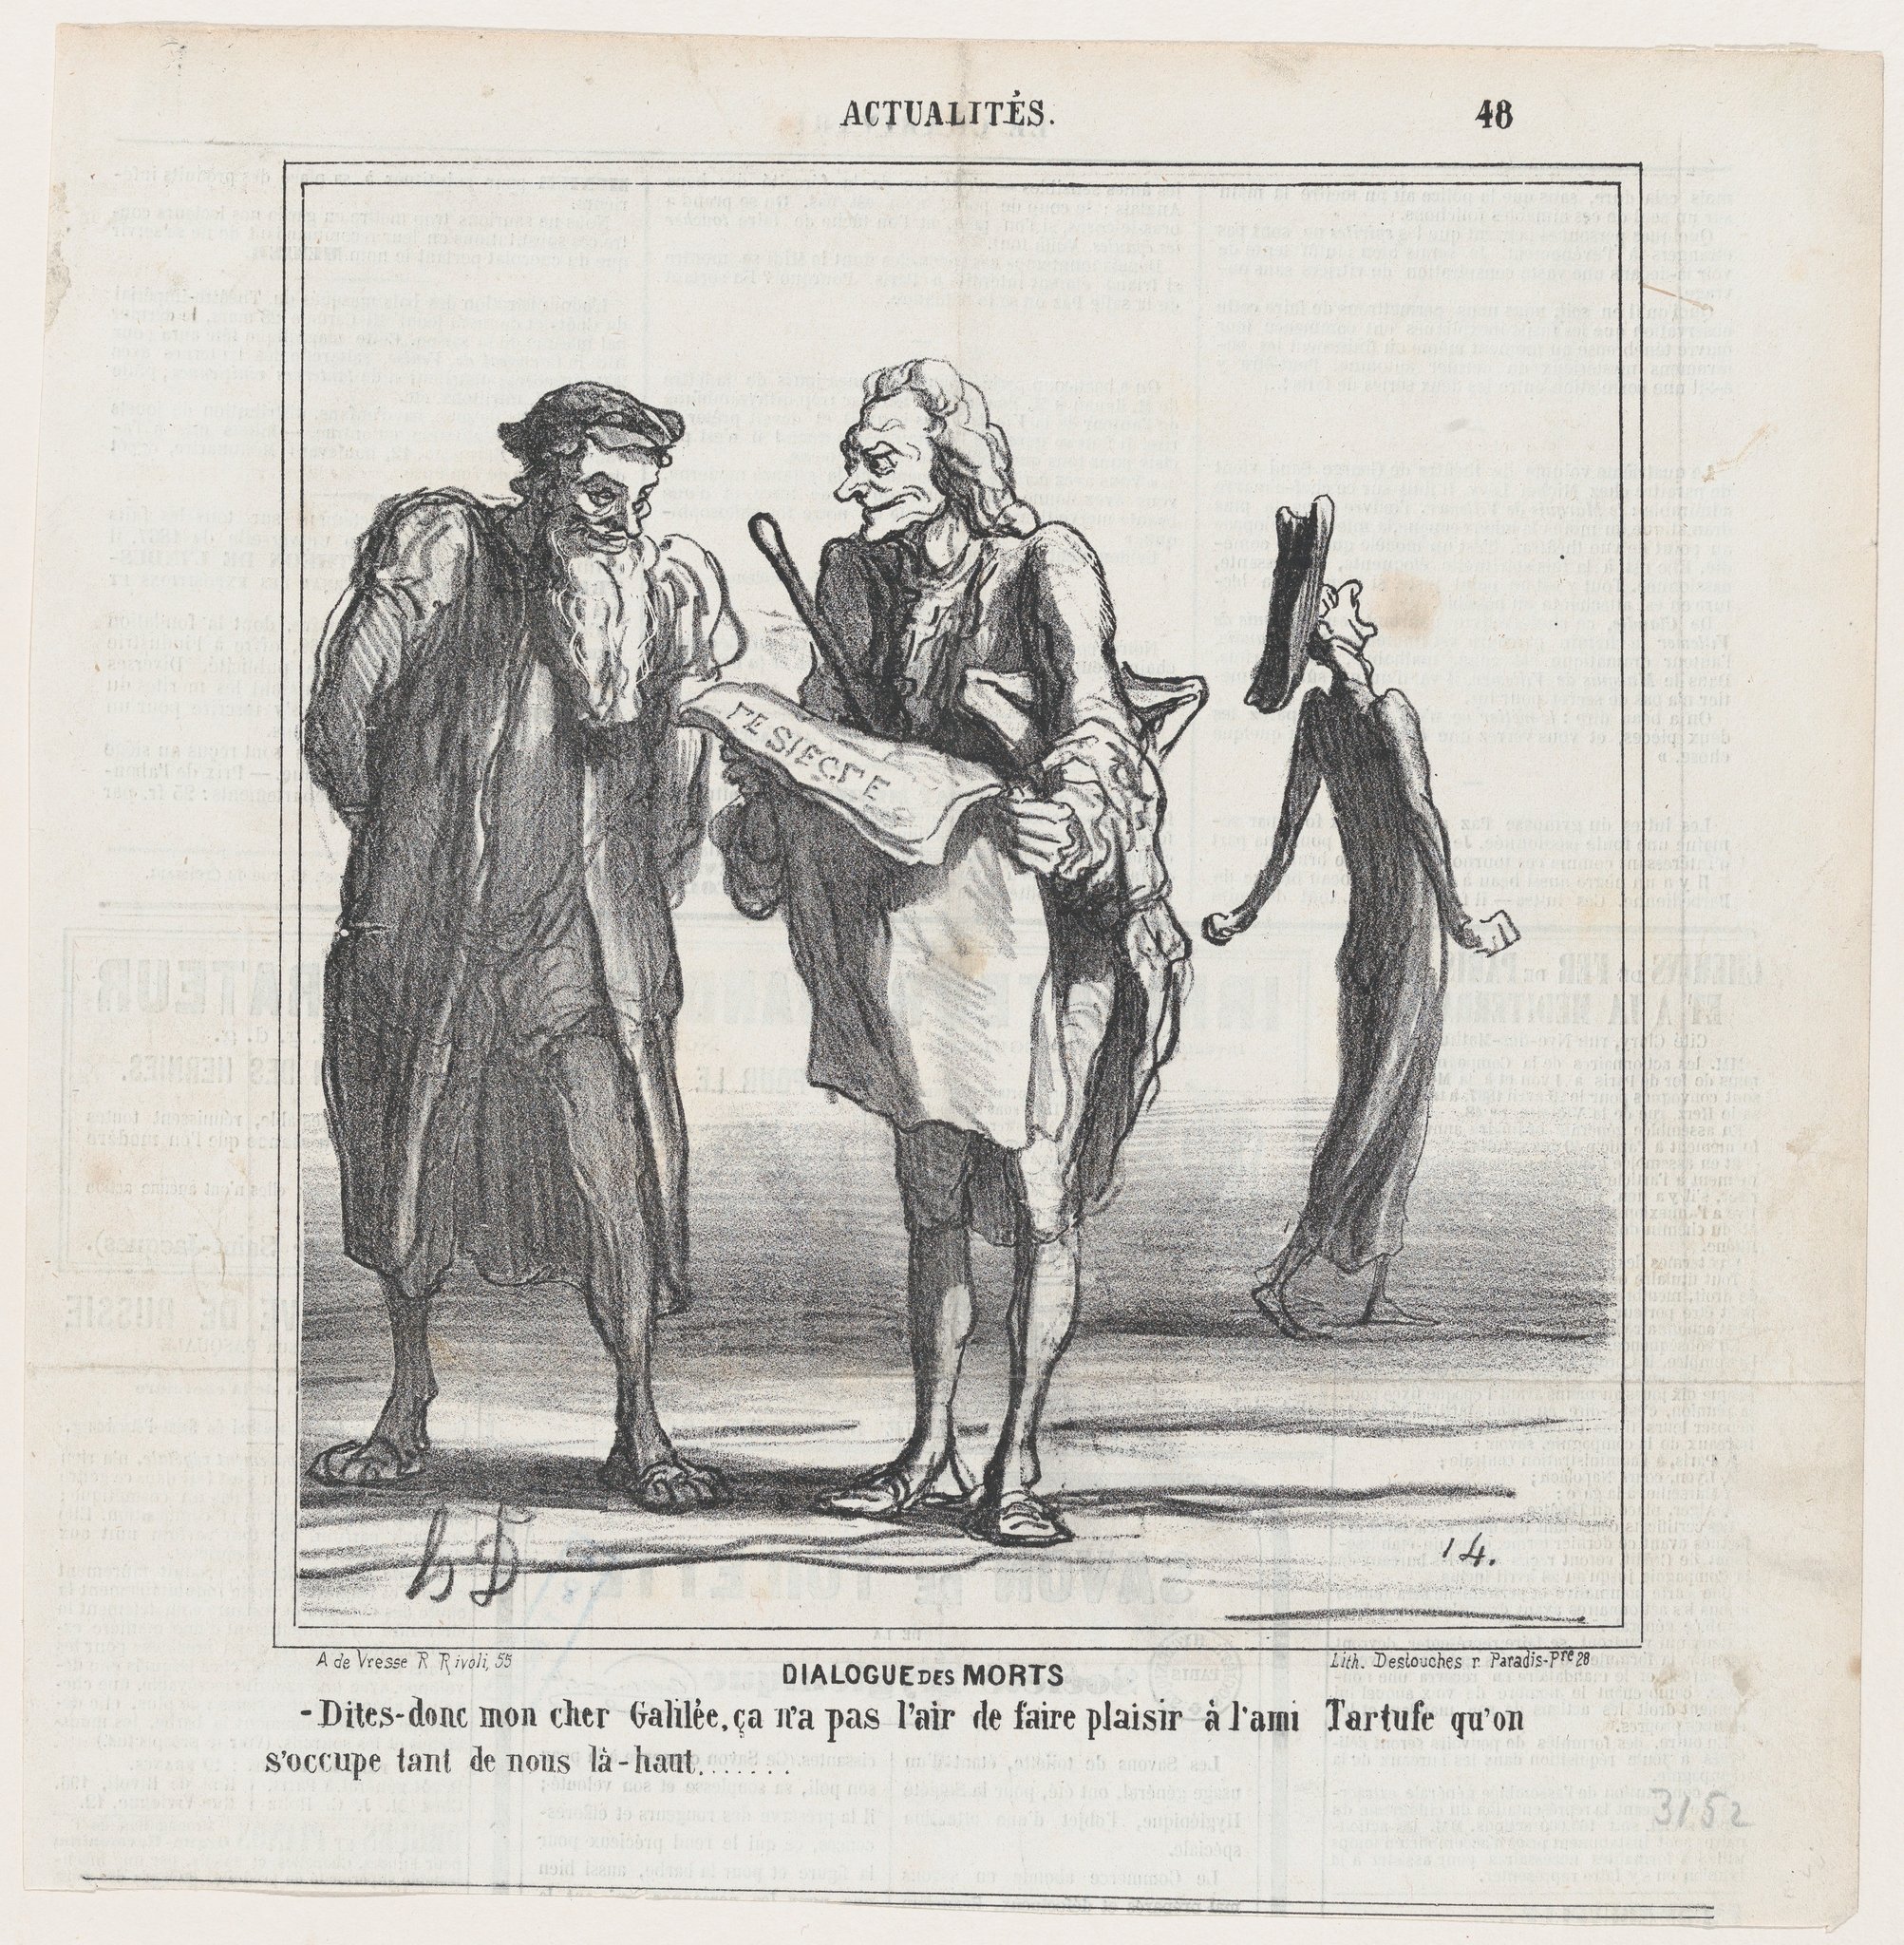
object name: print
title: Dialogue of the dead: Say, my dear Galileo, this will not please our old friend Tartuffe that they are paying so much attention to us, from 'News of the day,' published in "Le Charivari"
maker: honoré daumier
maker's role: artist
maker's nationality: french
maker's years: 1808-1879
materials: paper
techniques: lithograph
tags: men,reading